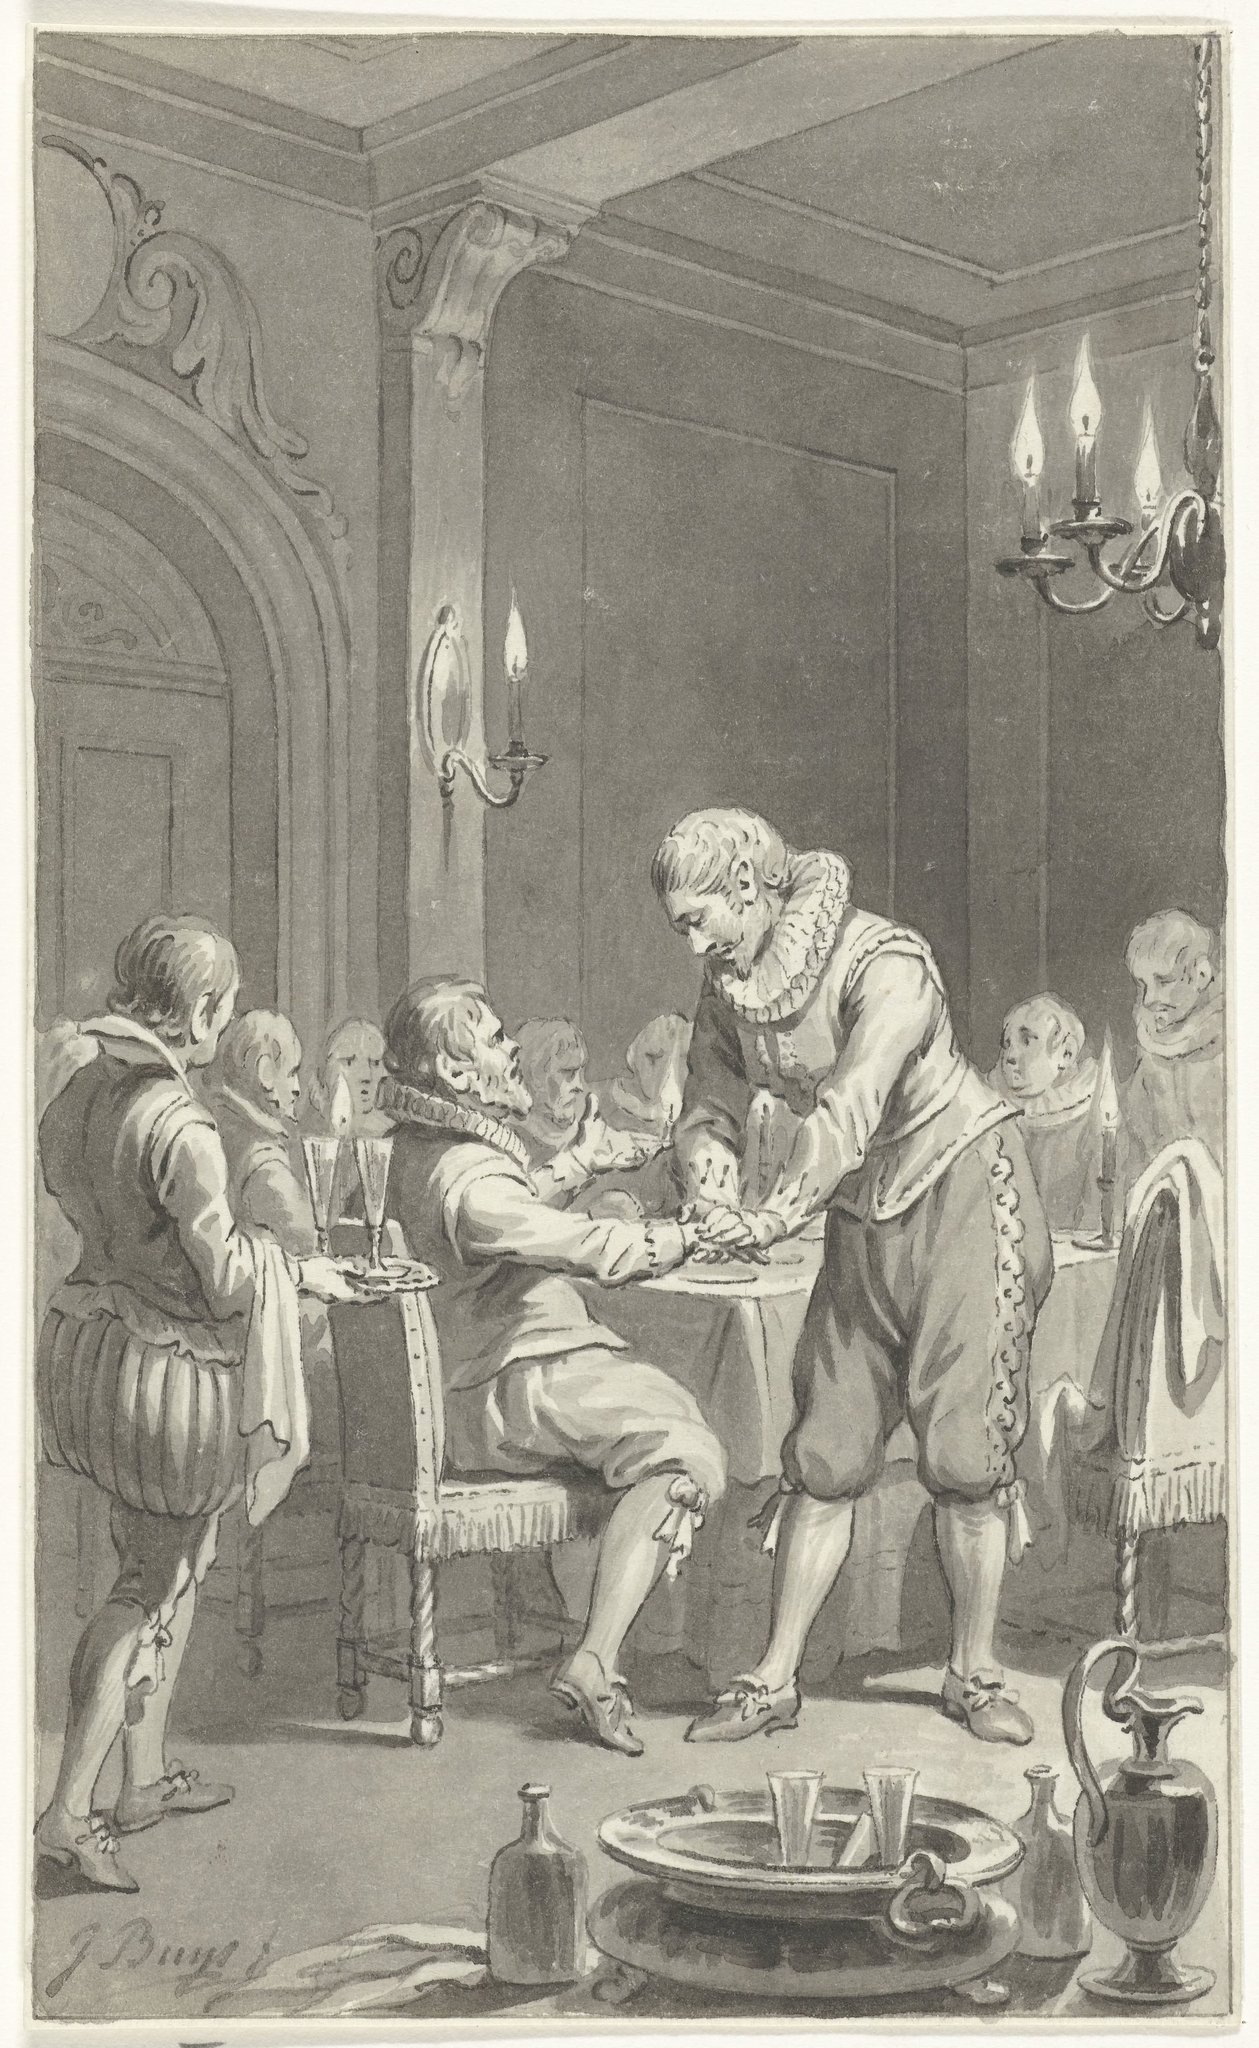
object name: drawing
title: Het verraad van Rennenberg aan burgemeester Hillebrands, 1580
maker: jacobus buys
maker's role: draughtsman, print maker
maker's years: 1724-1801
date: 1789-1791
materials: ink, paper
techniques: brush, pen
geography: netherlands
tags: mayor, groningen (province), politician, historical persons, evening meal, dinner, supper, treason, historical events and situations, traitor to one's country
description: Het verraad van Rennenberg aan burgemeester Hillebrands, 2 maart 1580. De graaf van Rennenberg, inmiddels overgegaan naar Spaanse zijde, verzekert het stadsbestuur van Groningen tijdens een maaltijd bij burgemeester Hillebrands van zijn trouw aan de Staten met een handdruk. Ontwerp voor een prent.